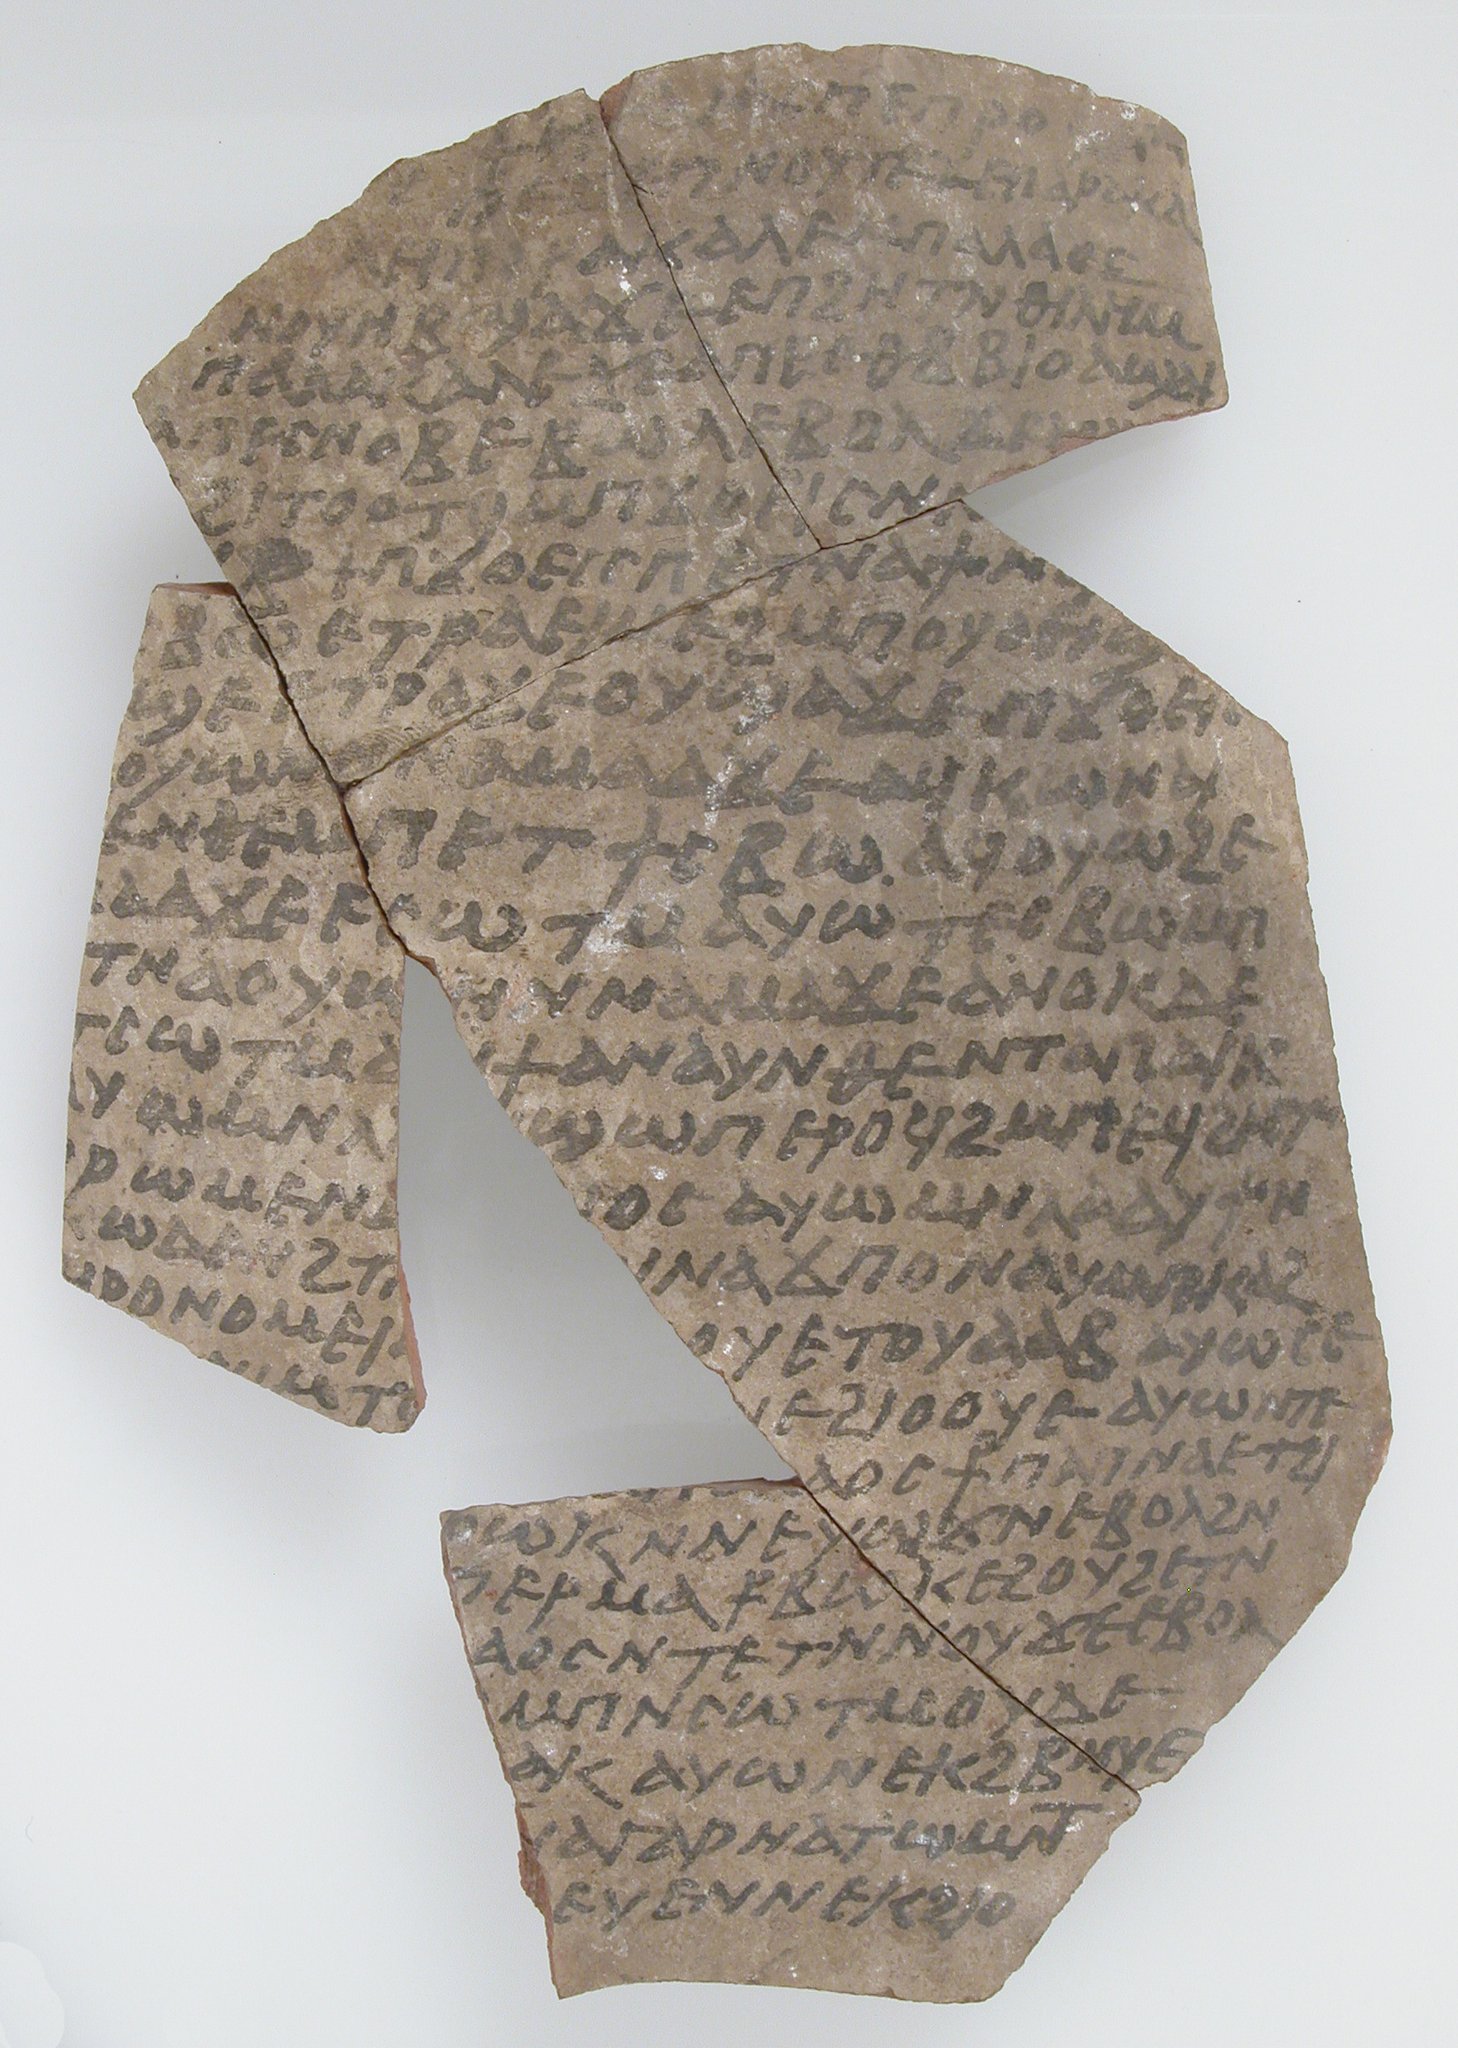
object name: ostrakon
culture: coptic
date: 601-700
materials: ink, pottery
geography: egypt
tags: documents